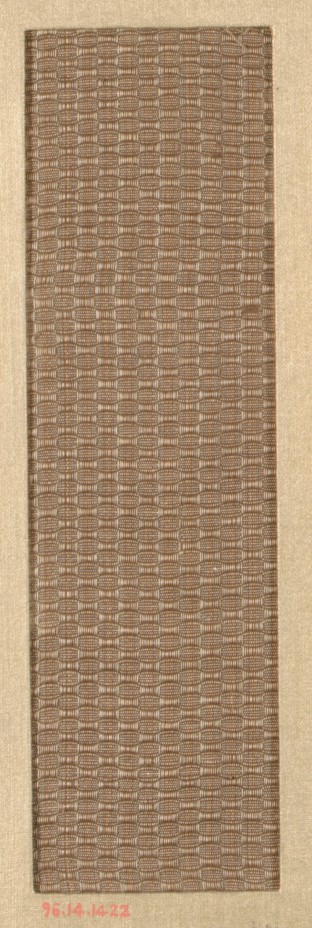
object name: piece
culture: japanese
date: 1701-1900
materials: silk